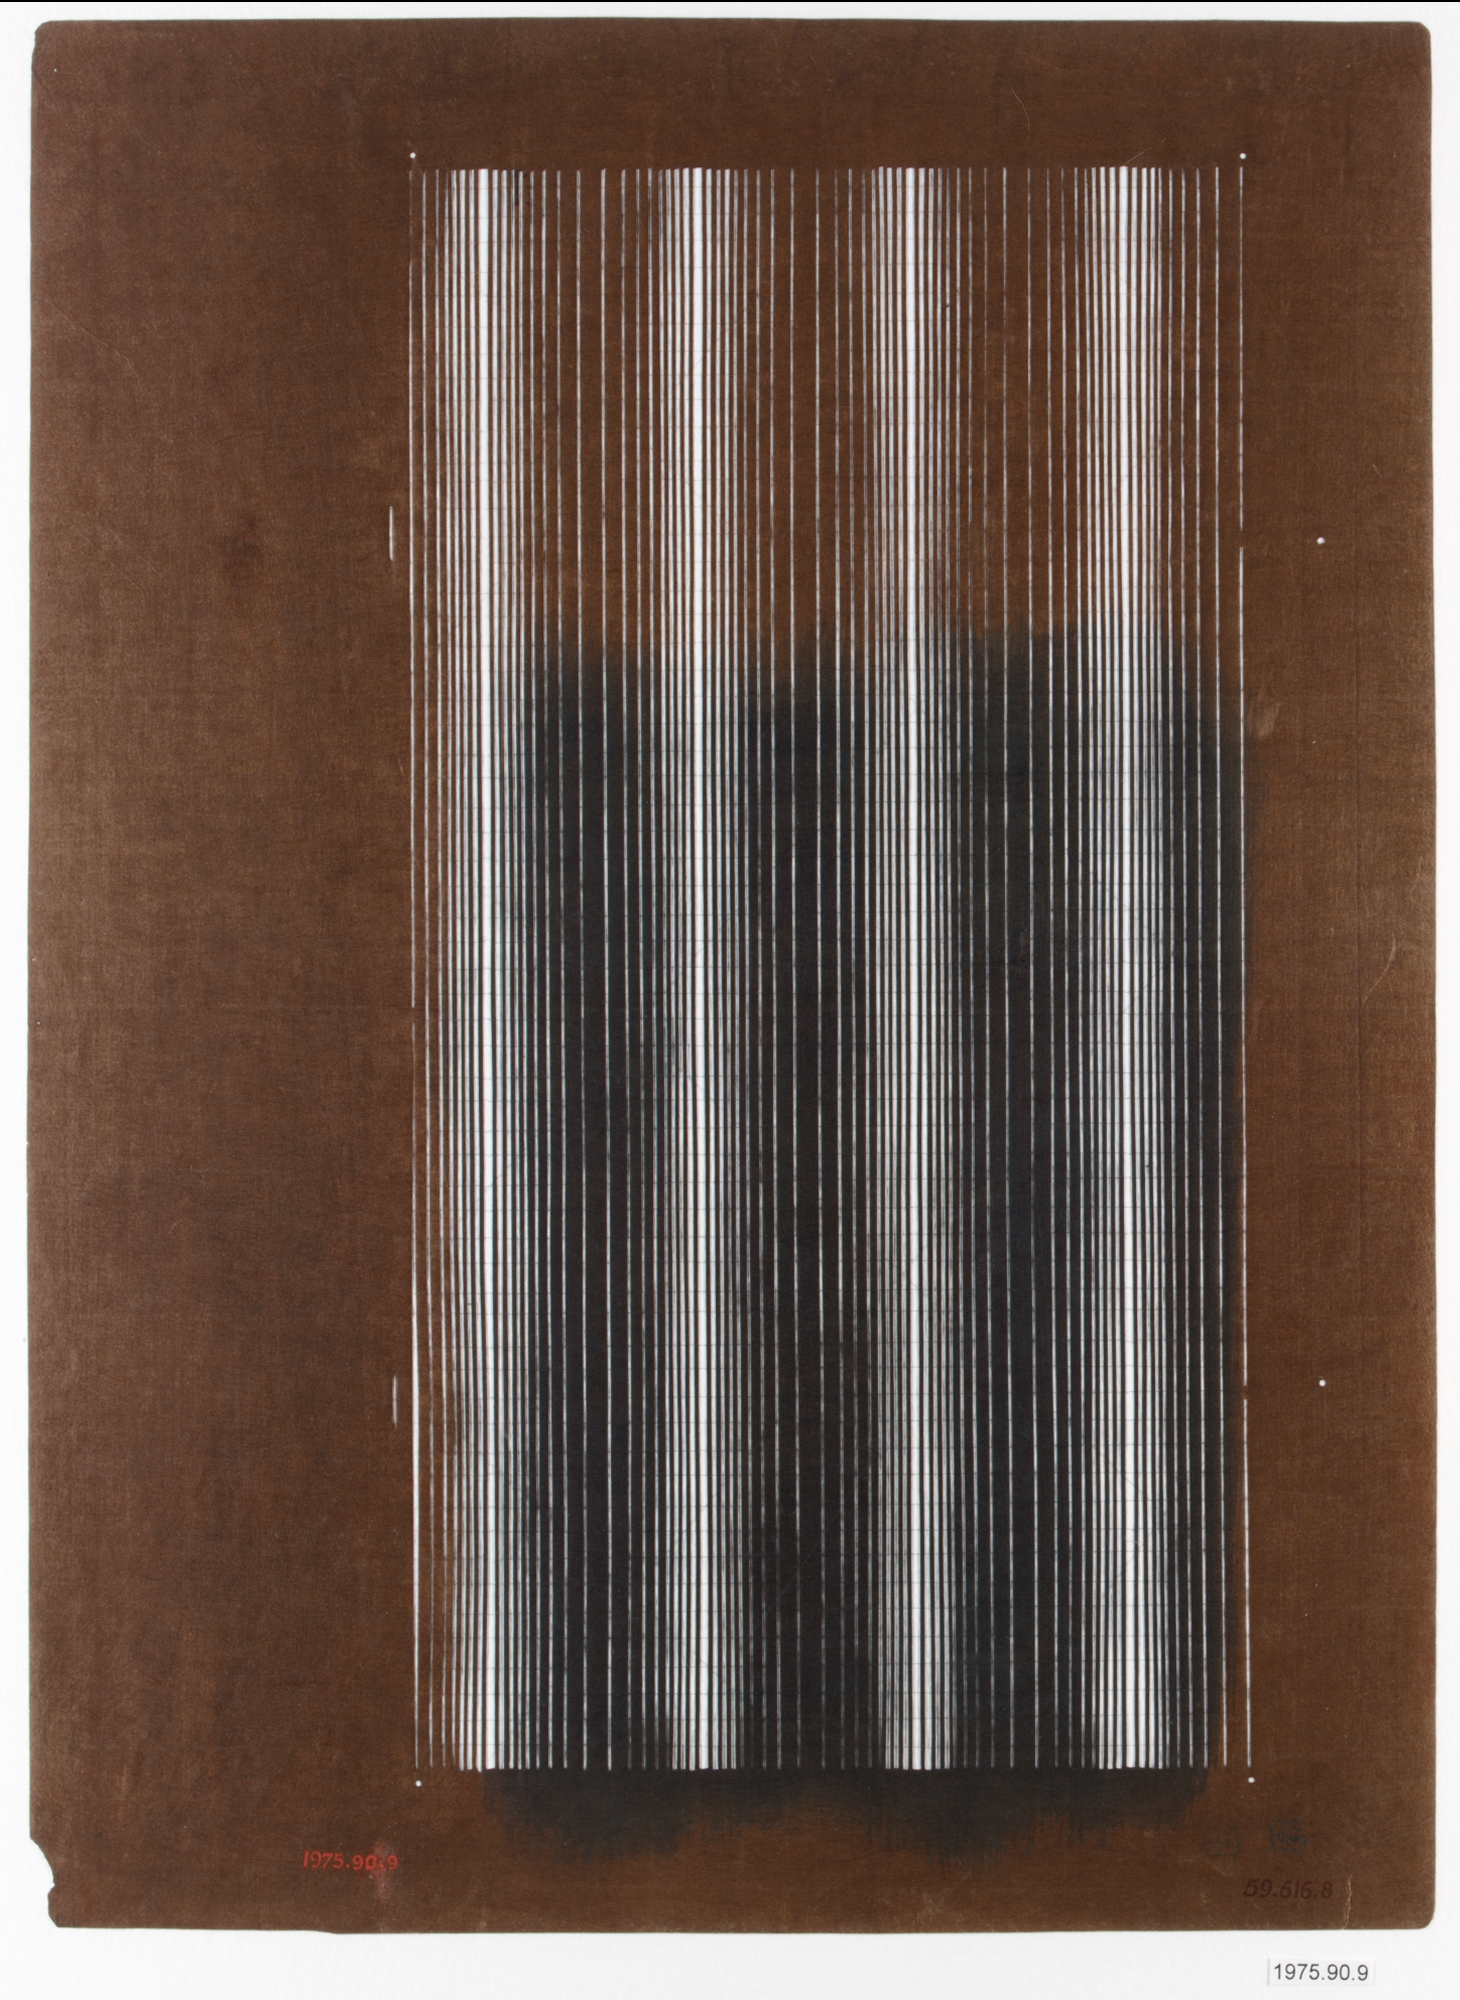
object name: stencil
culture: japanese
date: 1867-1933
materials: paper, silk